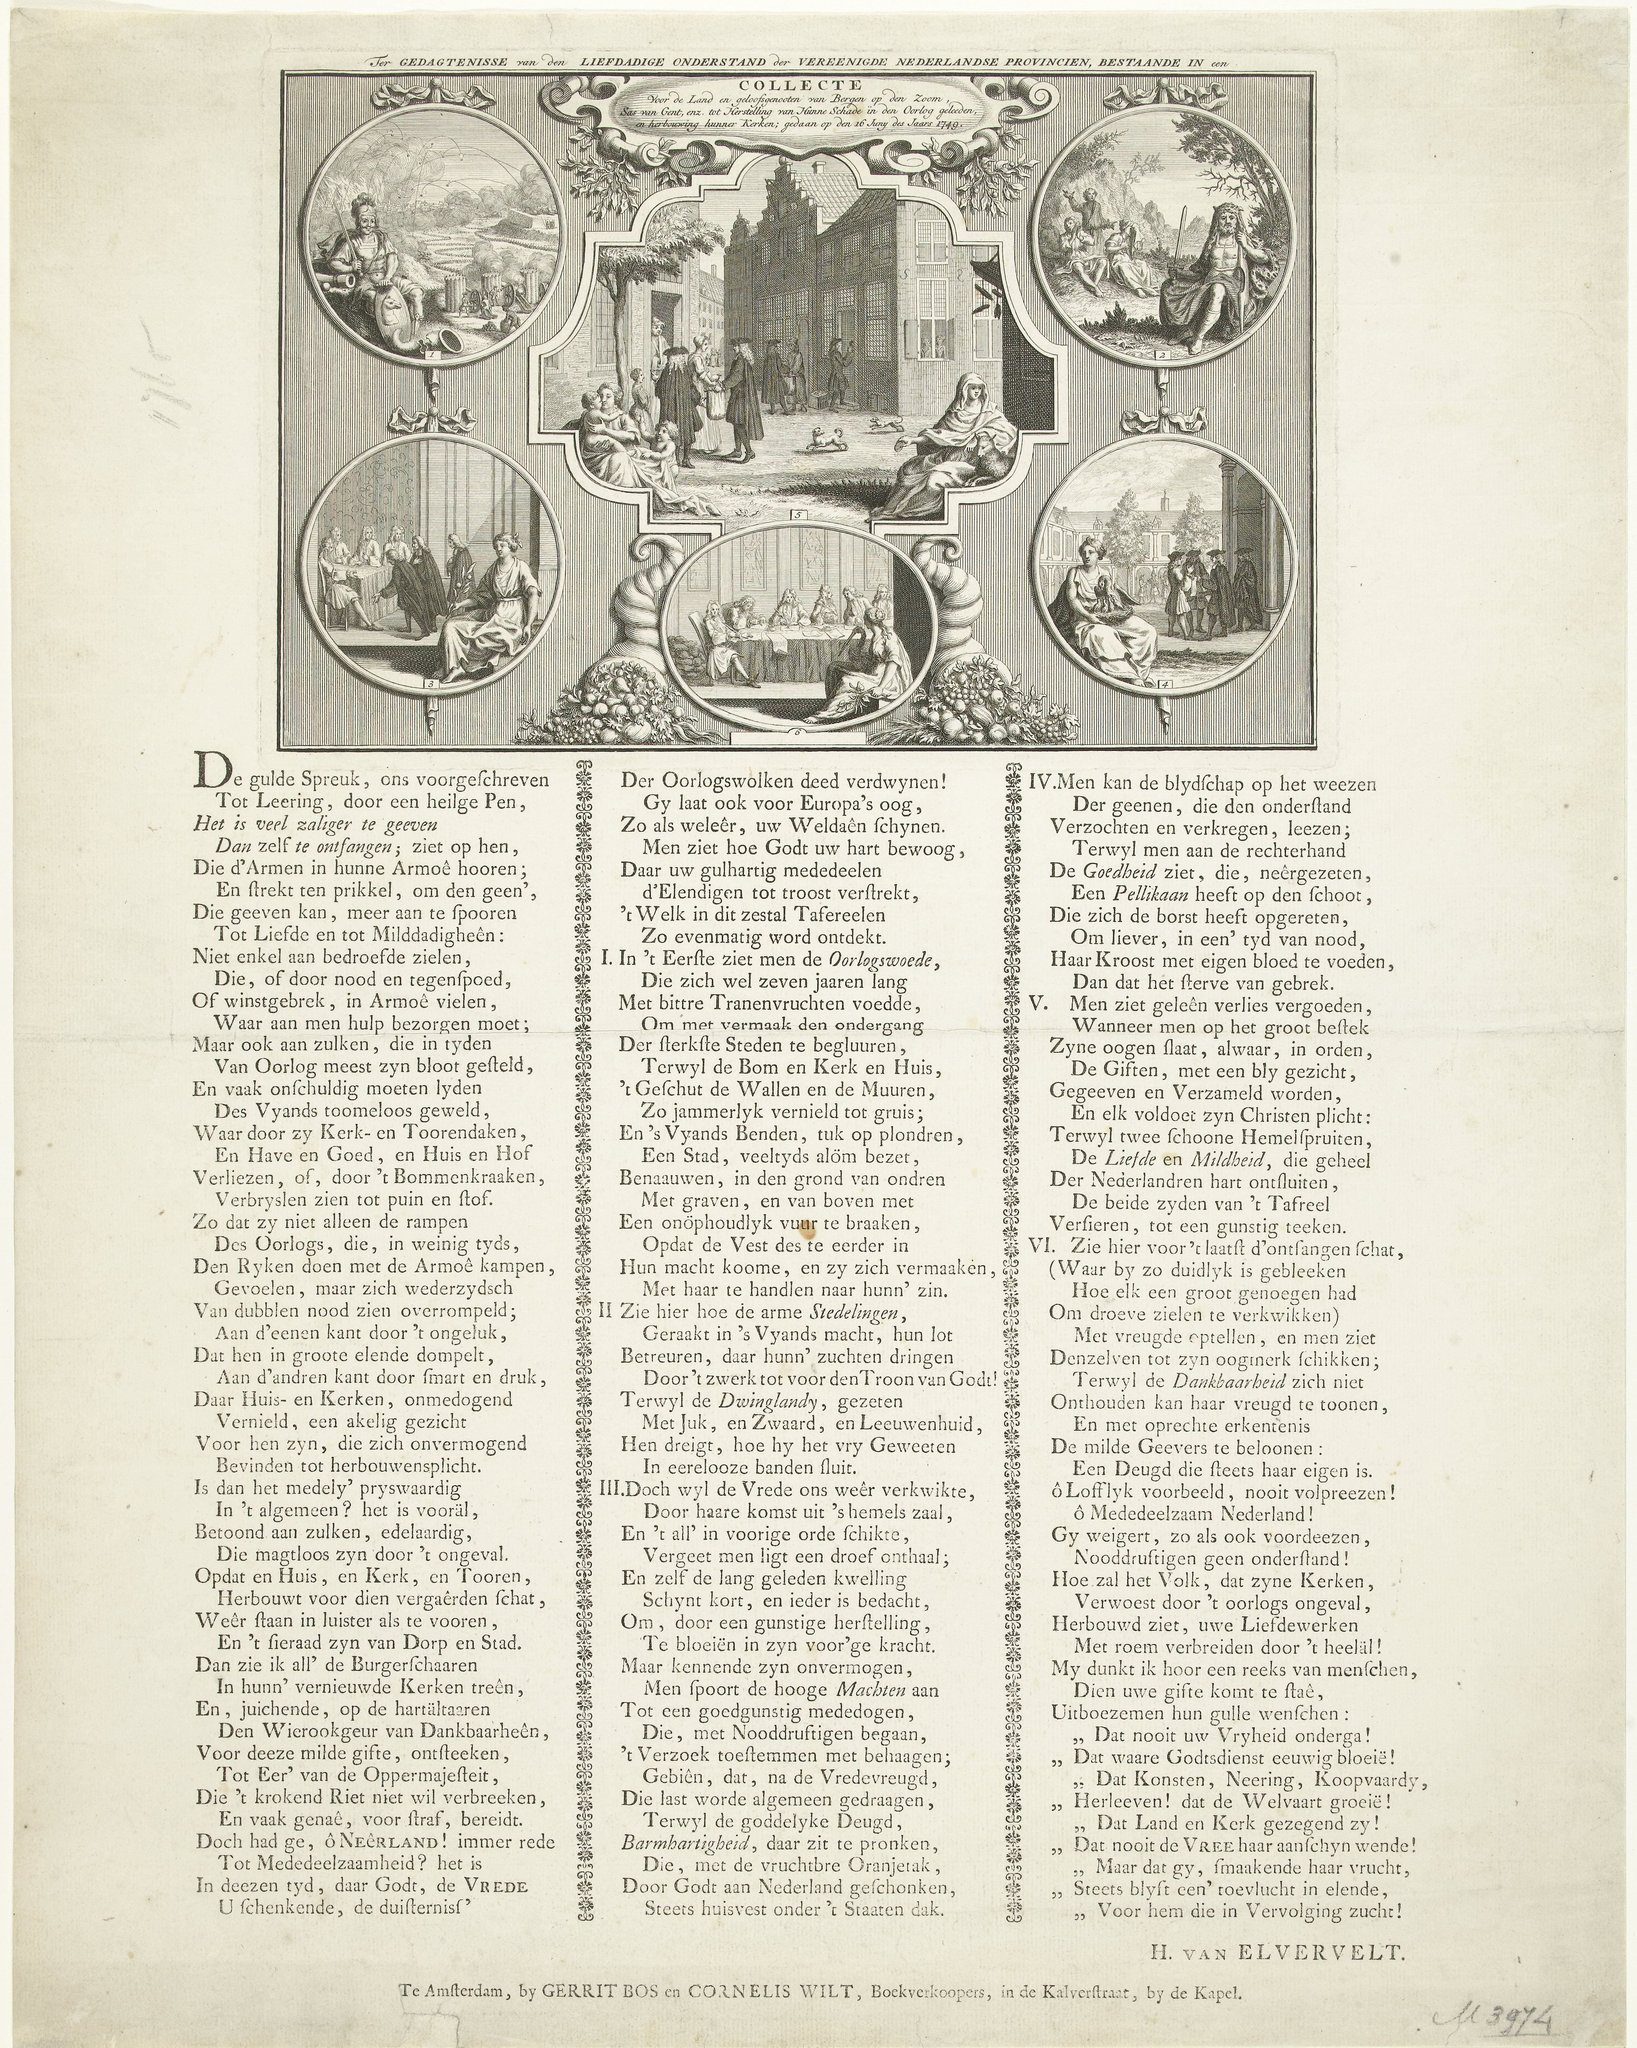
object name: print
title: Ter Gedagtenisse van den Liefdadige Onderstand der Vereenigde Nederlandse Provincien, Bestaande in een Collecte voor de Land en geloofsgenooten van Bergen op Zoom, Sas van Gent, enz. tot Herstelling van Hunne Schade in den Oorlog geleeden, en herbouwing hunner Kerken; gedaan op den 16 Juny des Jaars 1749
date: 1731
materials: paper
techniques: engraving, etching, letterpress printing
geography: amsterdam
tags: giving alms; collection, bergen op zoom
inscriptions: collector's mark: Lugt 2228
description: Collecte voor bijstand aan de getroffenen en herstel van oorlogsschade geleden in Bergen op Zoom en andere steden, 1749. Plaat met zes deelscènes van de oorlog en de collectes. Op het blad onder de plaat een vers in drie kolommen.